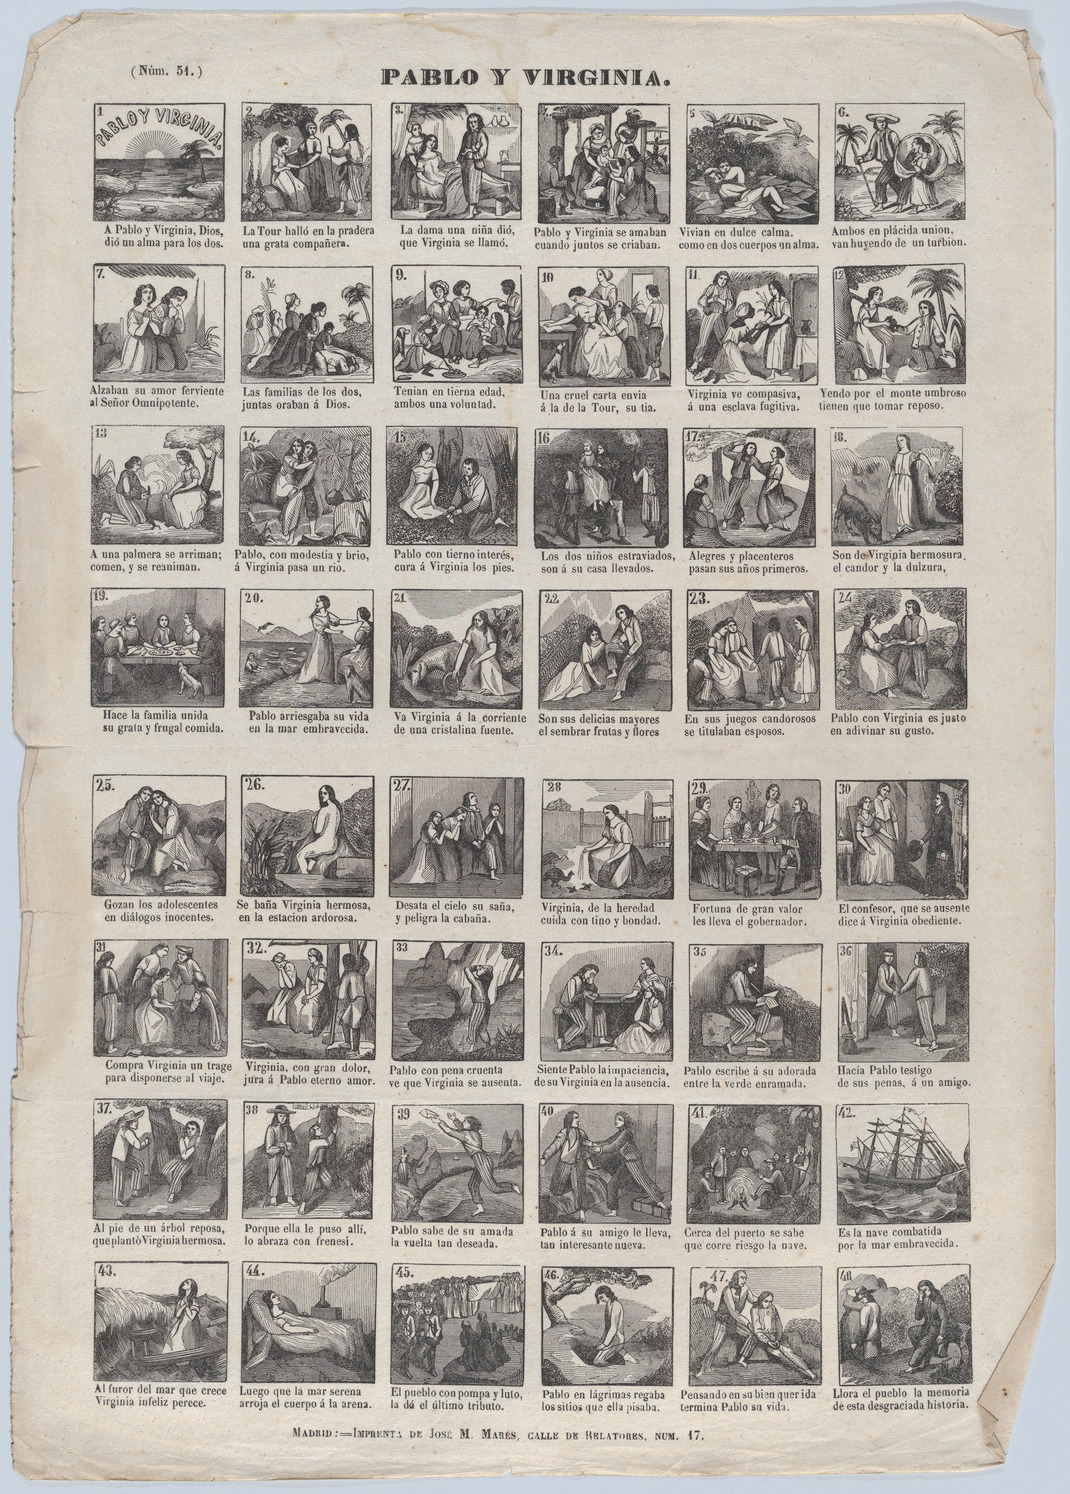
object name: print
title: Broadside with 48 scenes relating to the live of Pablo and Virginia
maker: josé maría marés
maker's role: publisher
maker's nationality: spanish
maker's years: 1850-1870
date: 1860-1870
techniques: engraving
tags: men,women